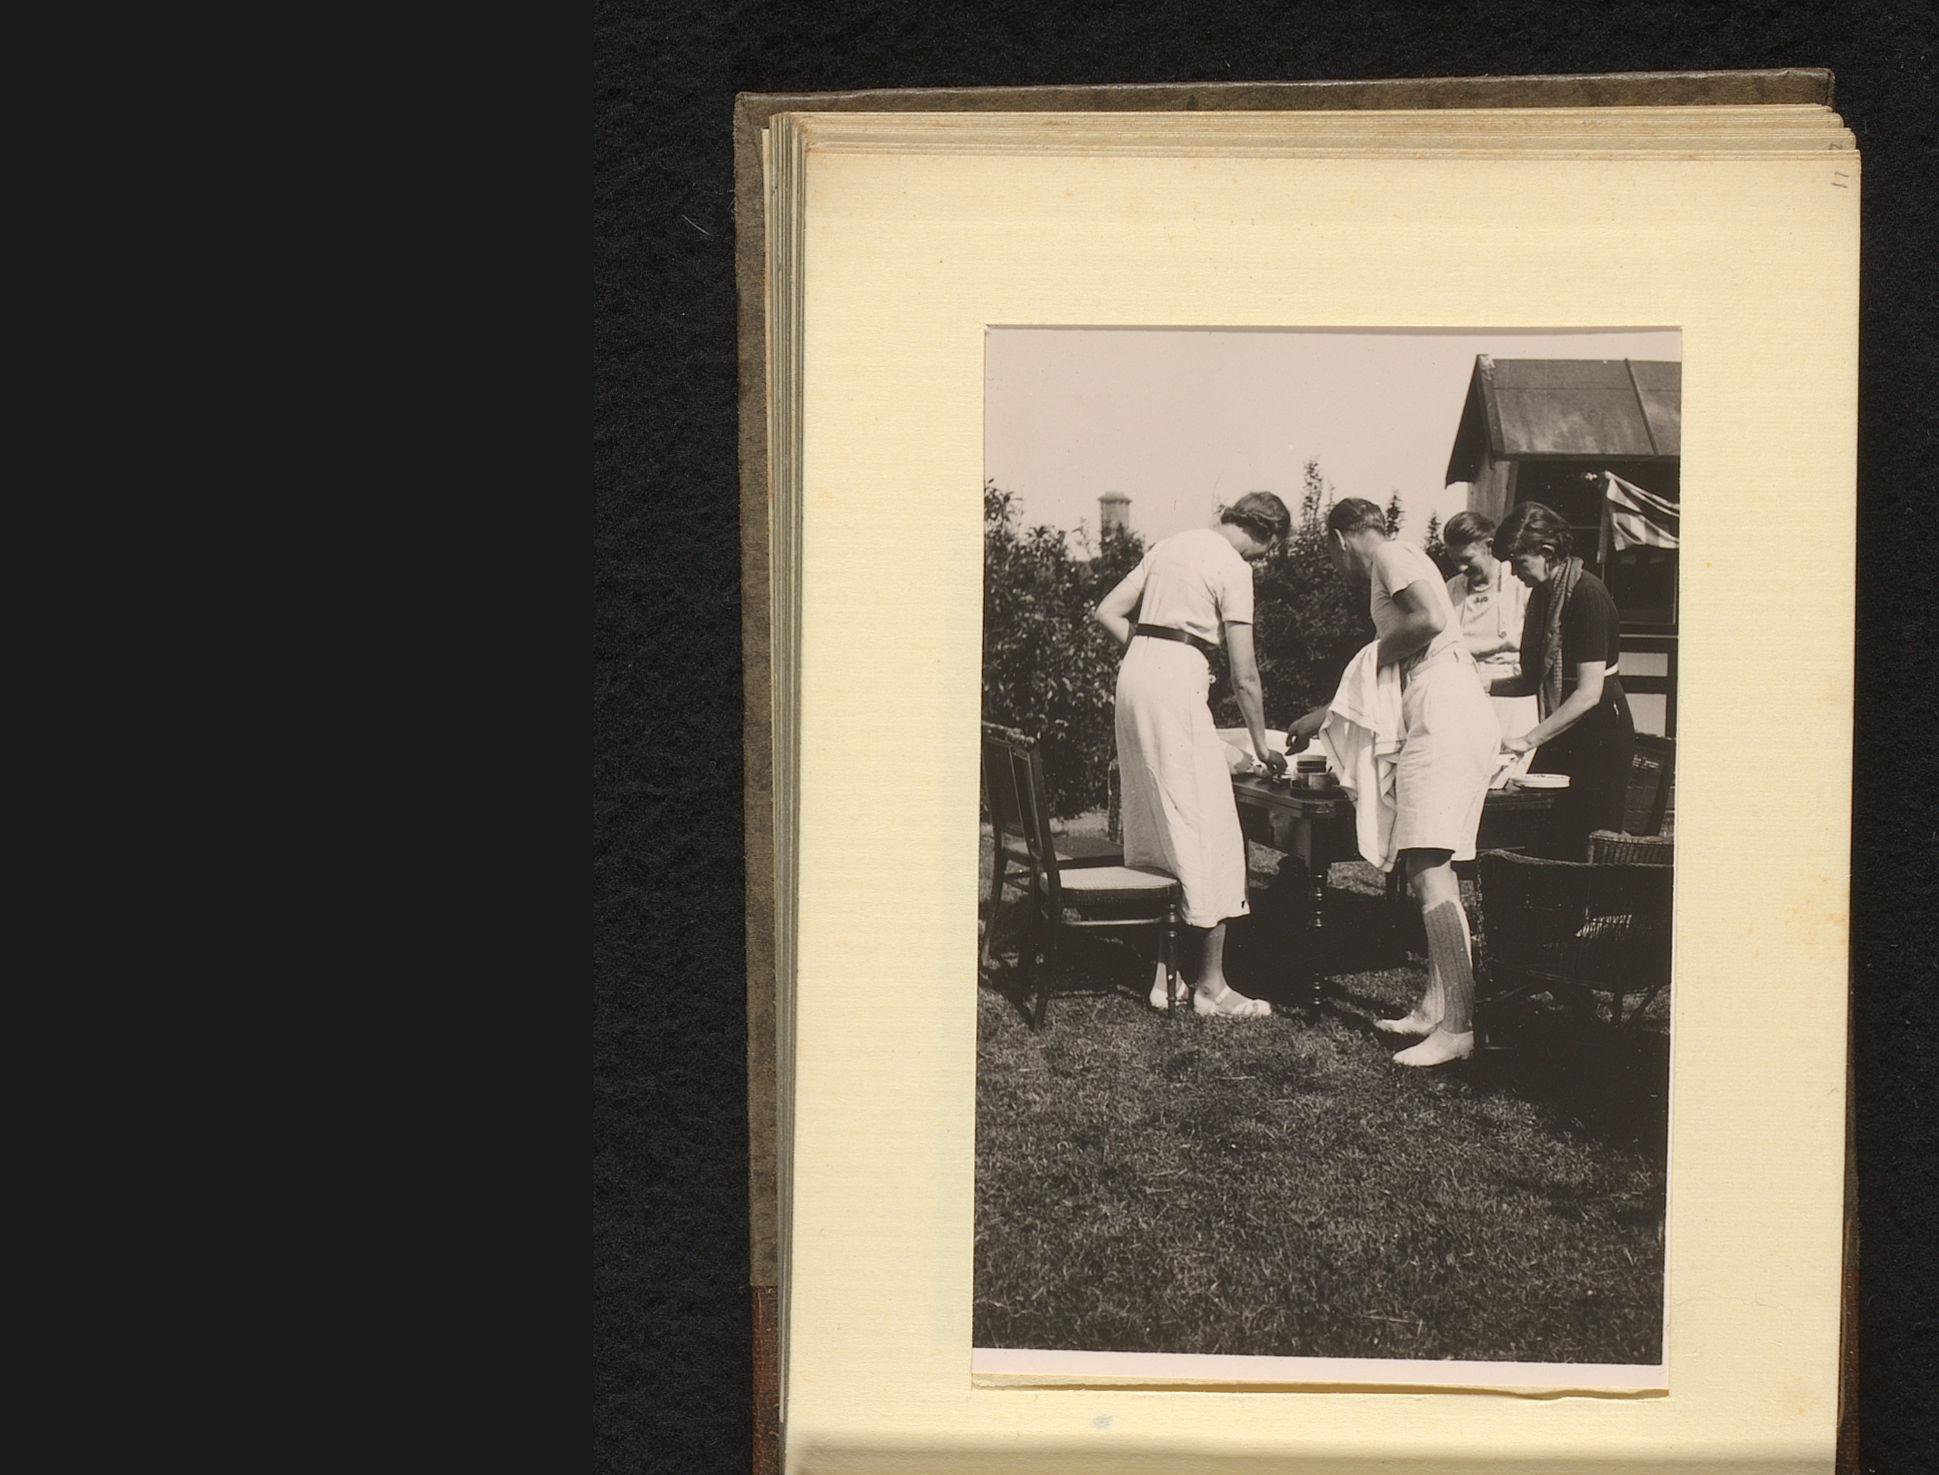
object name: album leaf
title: Mensen op een terras in een tuin, tijdens het dekken of afruimen van de tafel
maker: norbert van den berg (1901-1972)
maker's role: amateurfotograaf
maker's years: 1901-1972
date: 1935-1950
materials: paper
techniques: gelatin silver print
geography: netherlands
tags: laying the table, garden, terrace